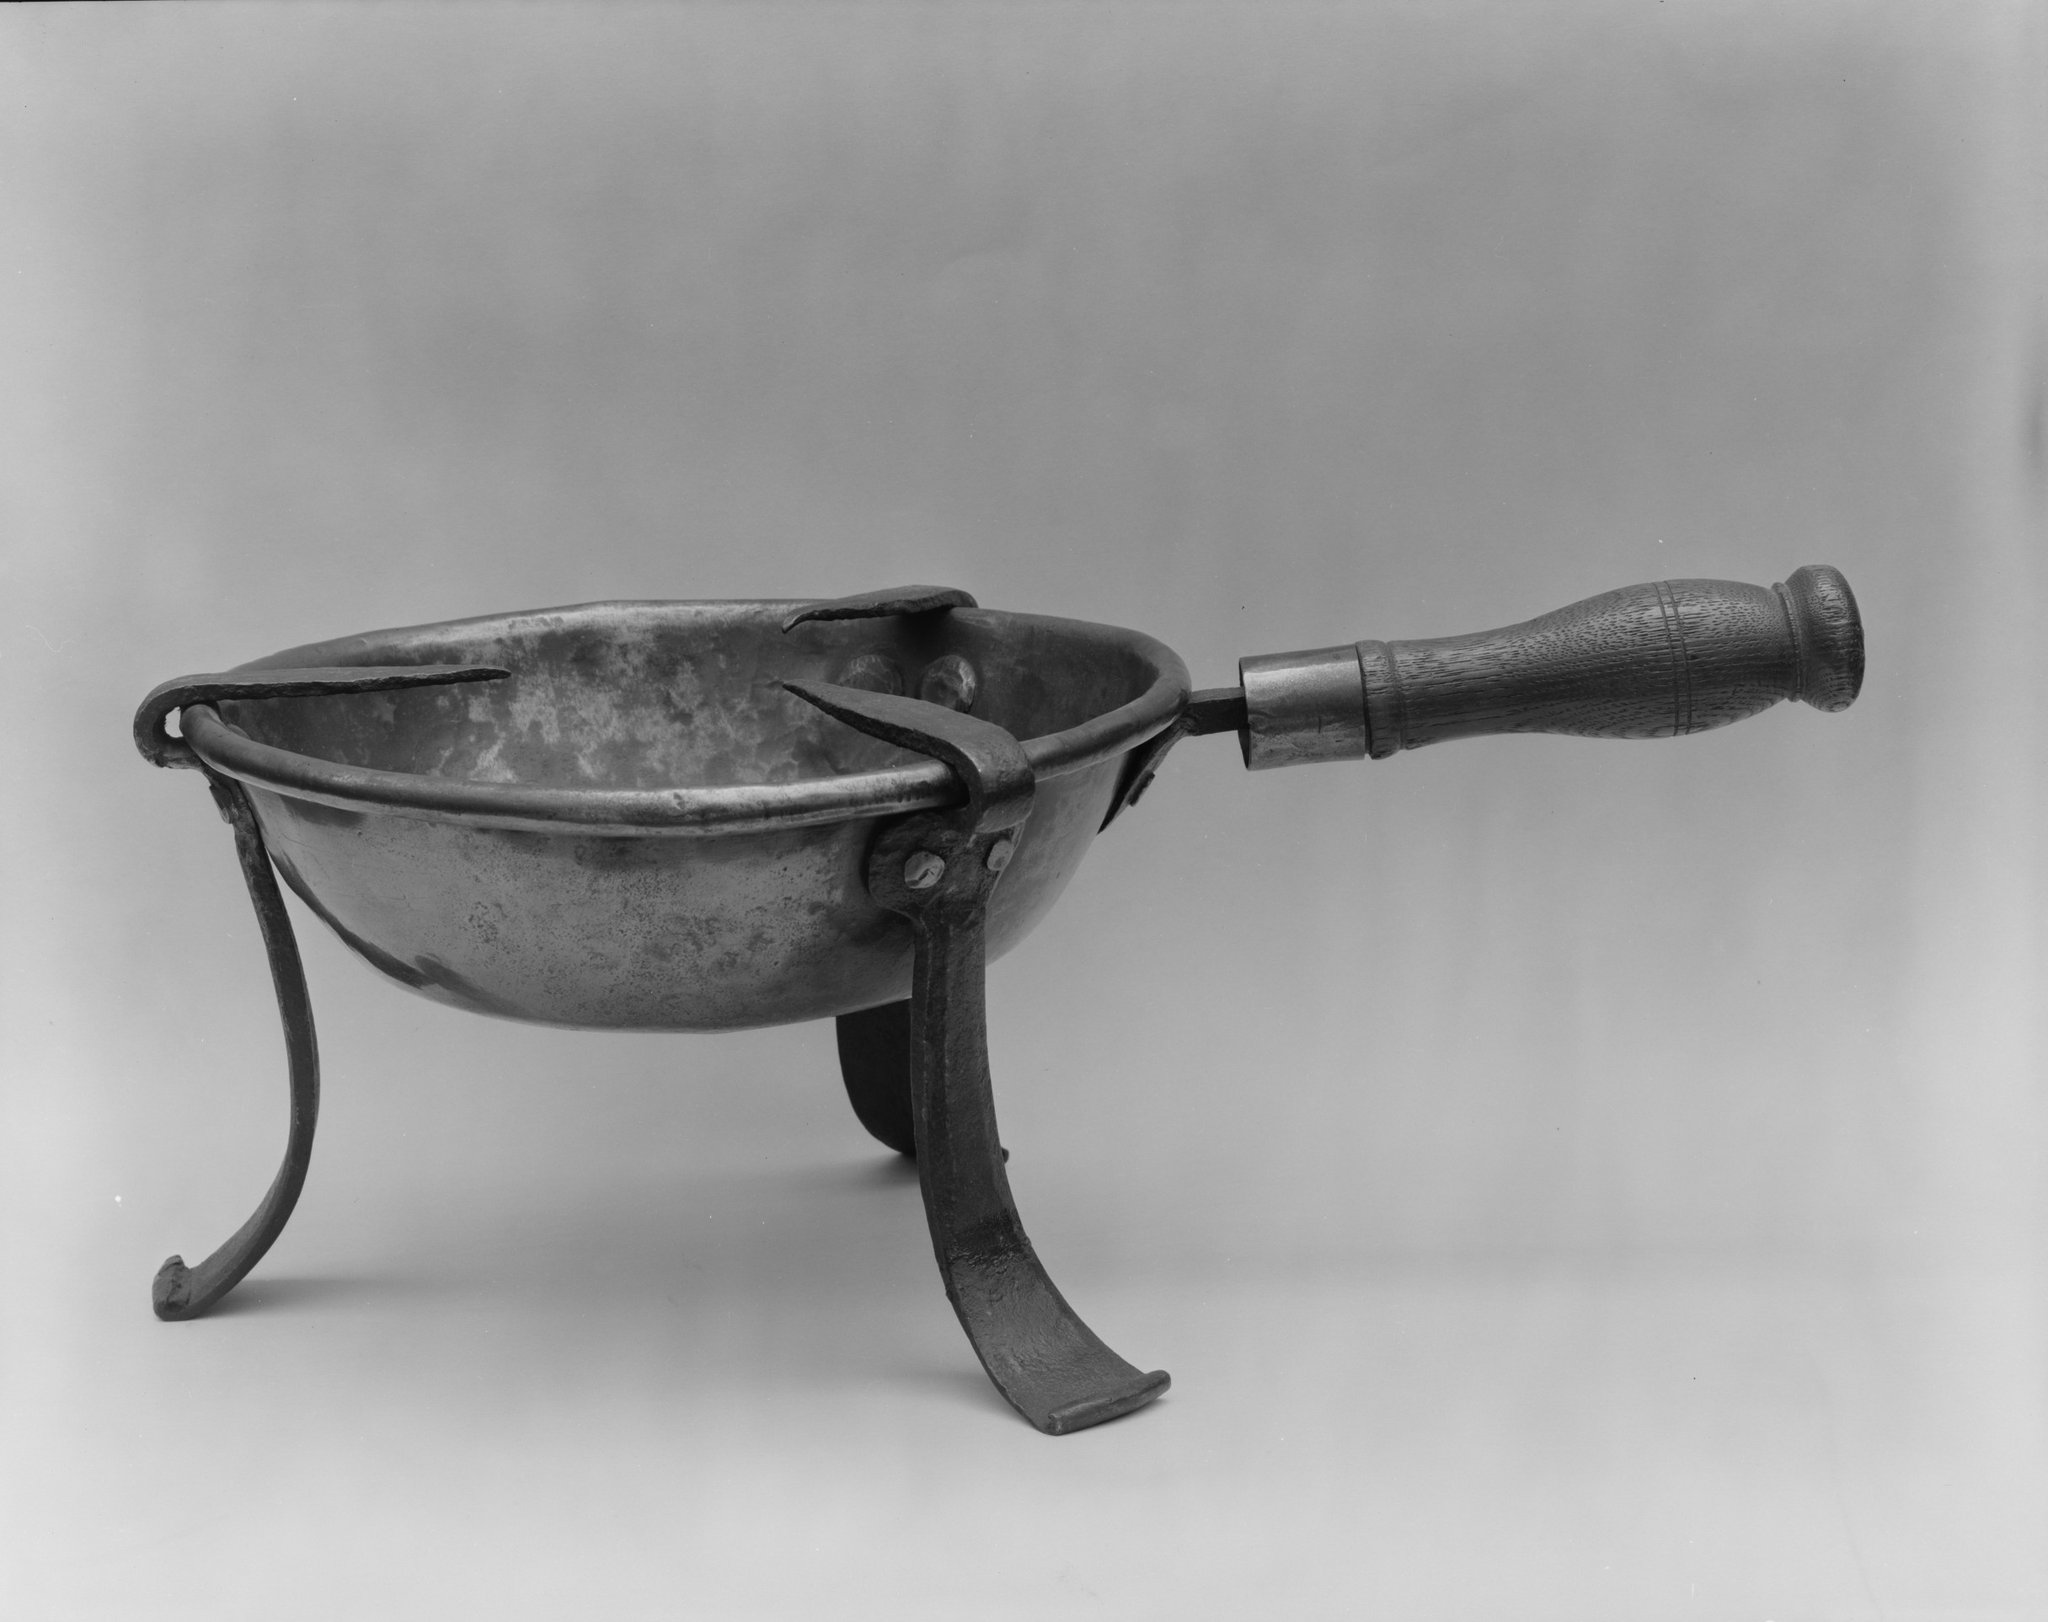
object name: brazier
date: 1700-1800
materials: copper, iron, wood